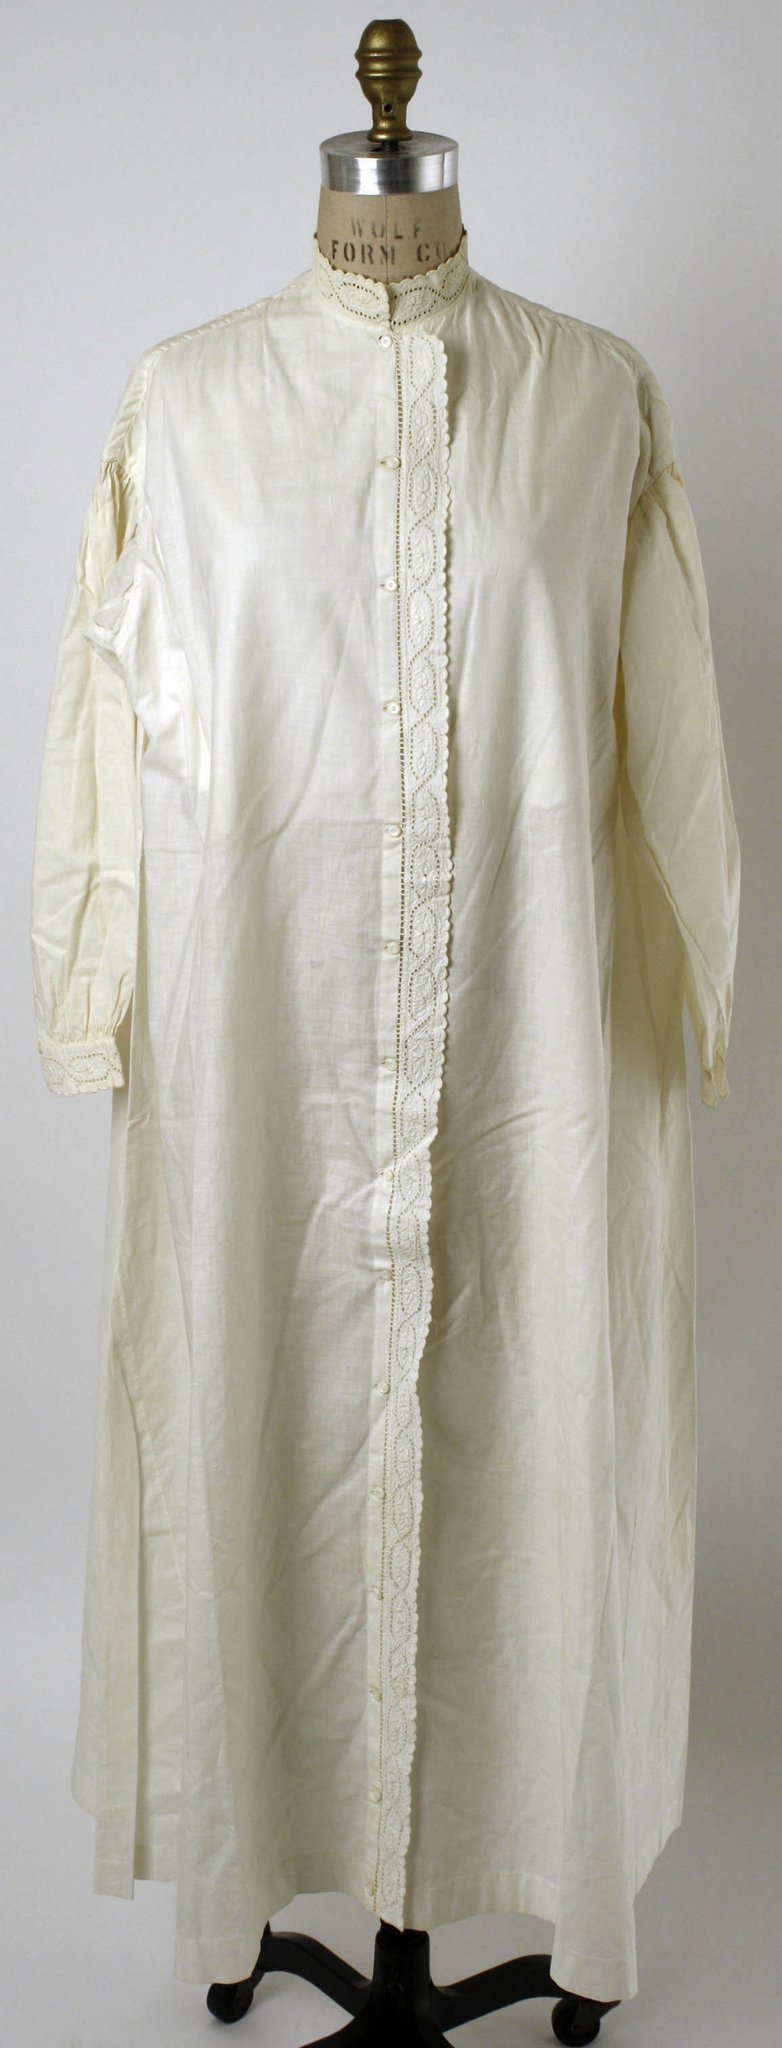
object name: nightgown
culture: american or european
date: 1850-1859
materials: cotton